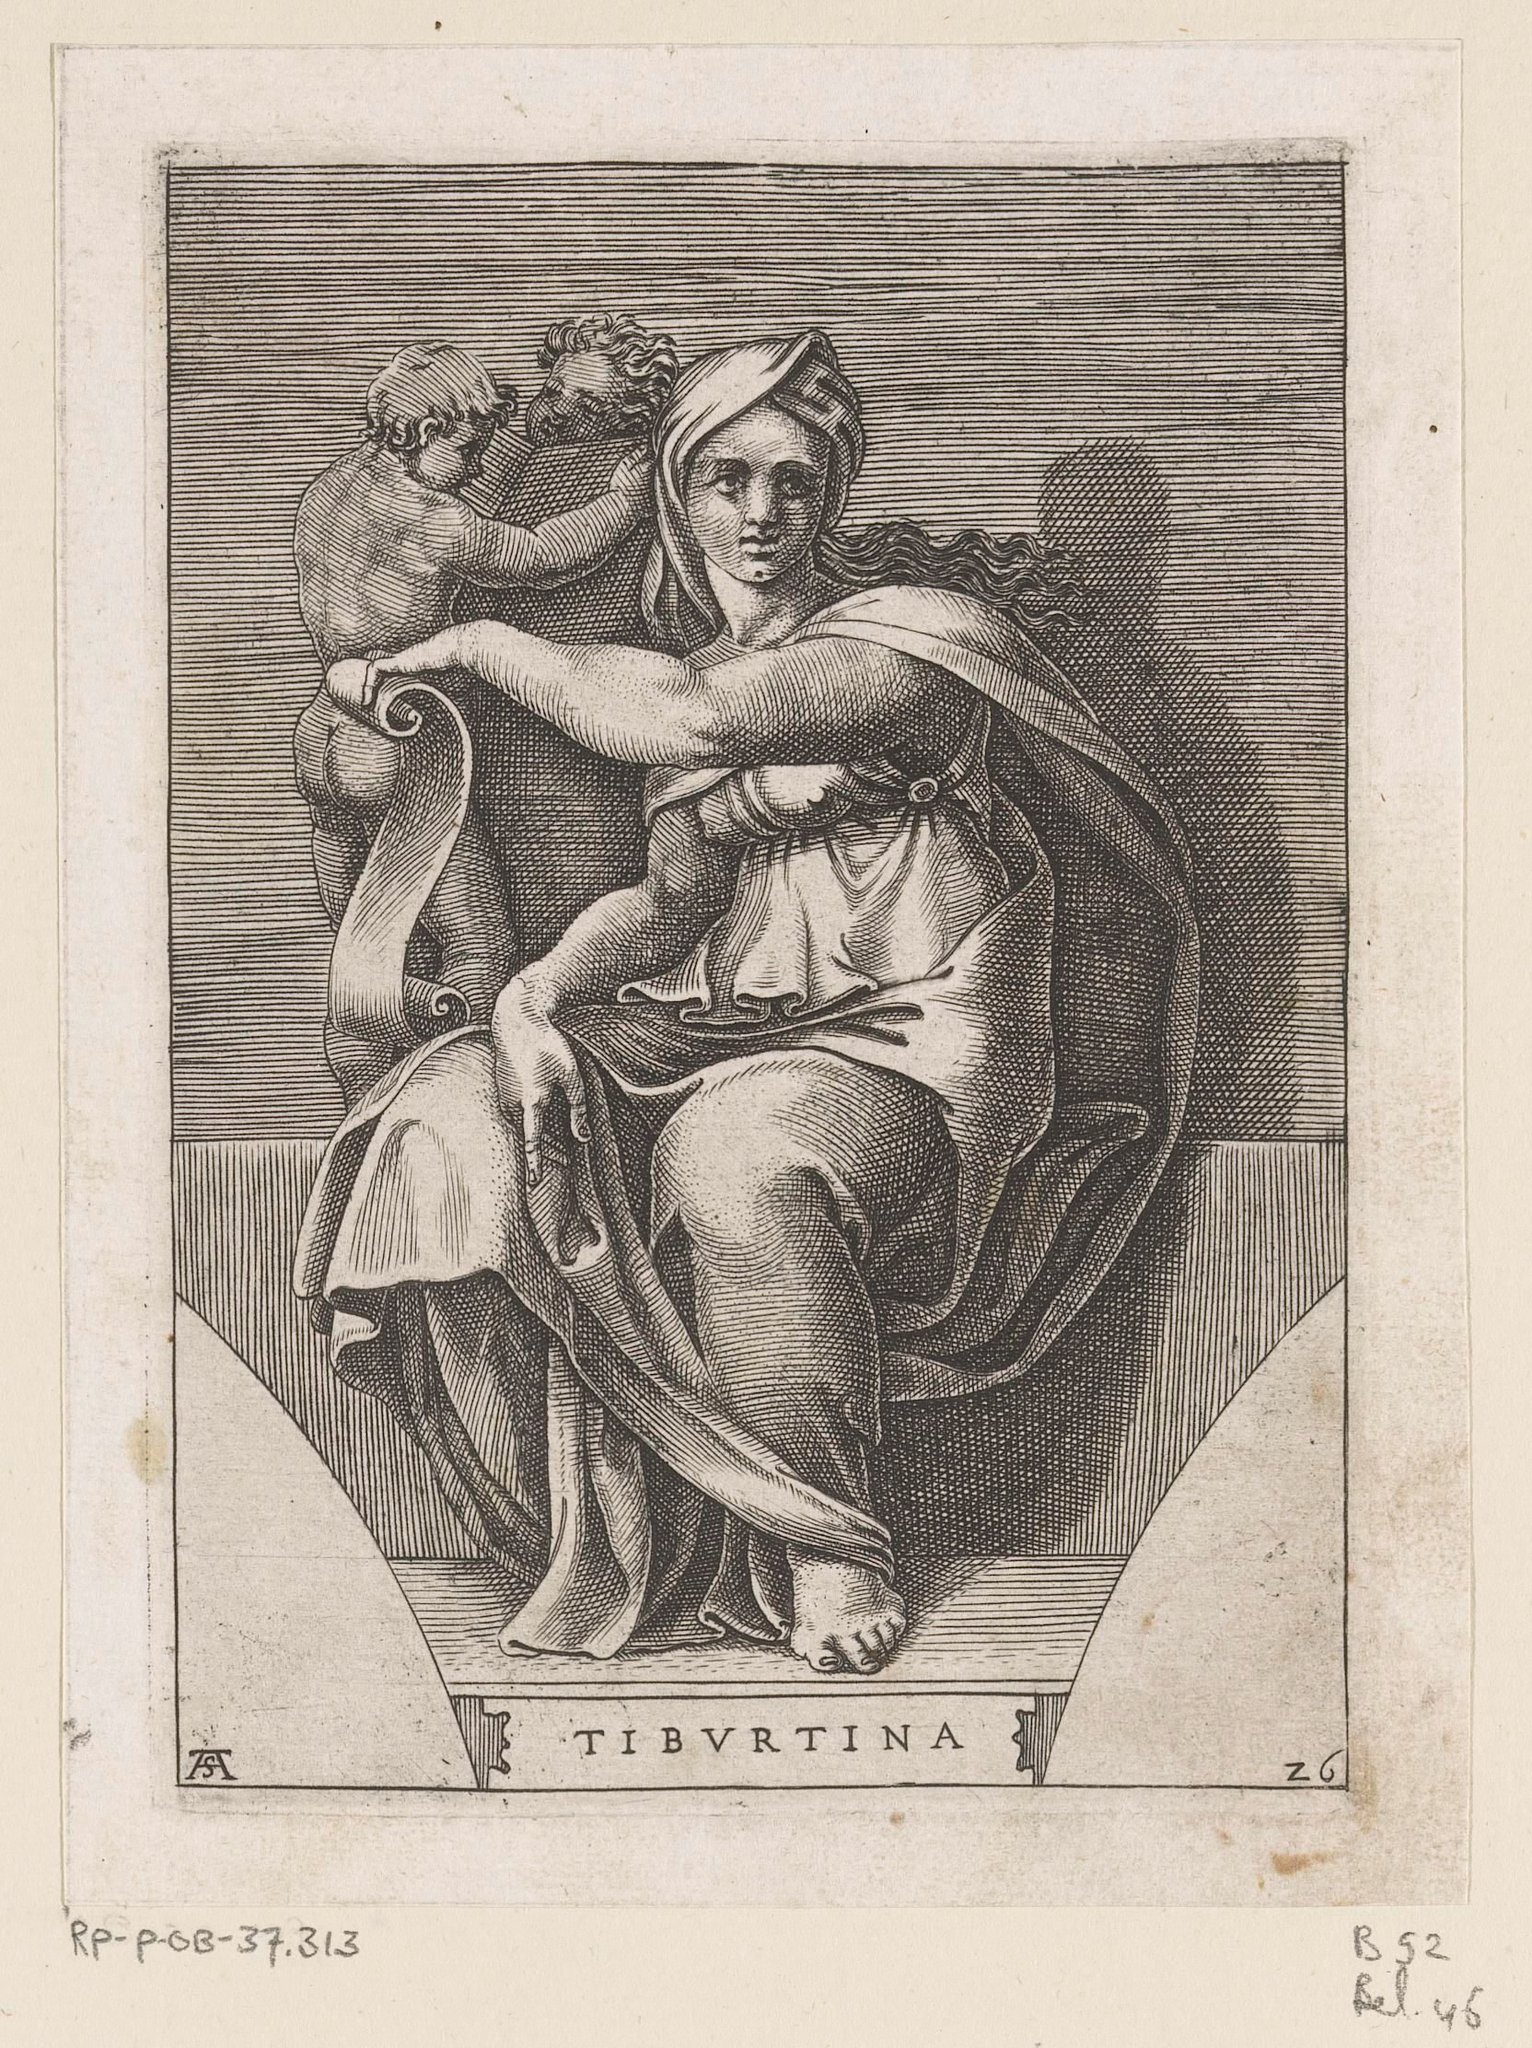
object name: print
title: Schilderingen in de Sixtijnse kapel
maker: adamo scultori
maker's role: painter, print maker, sculptor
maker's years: 1530-1585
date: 1585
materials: paper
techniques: engraving, intaglio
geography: italy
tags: sibyls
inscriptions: collector's mark: Lugt 240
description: Tiburtijnse Sibille zittend met een boekrol. Links twee kleine figuren. Eén van de Sibillen van Michelangelo's plafondschildering. Titel in ondermarge en genummerd rechtsonder: 26.